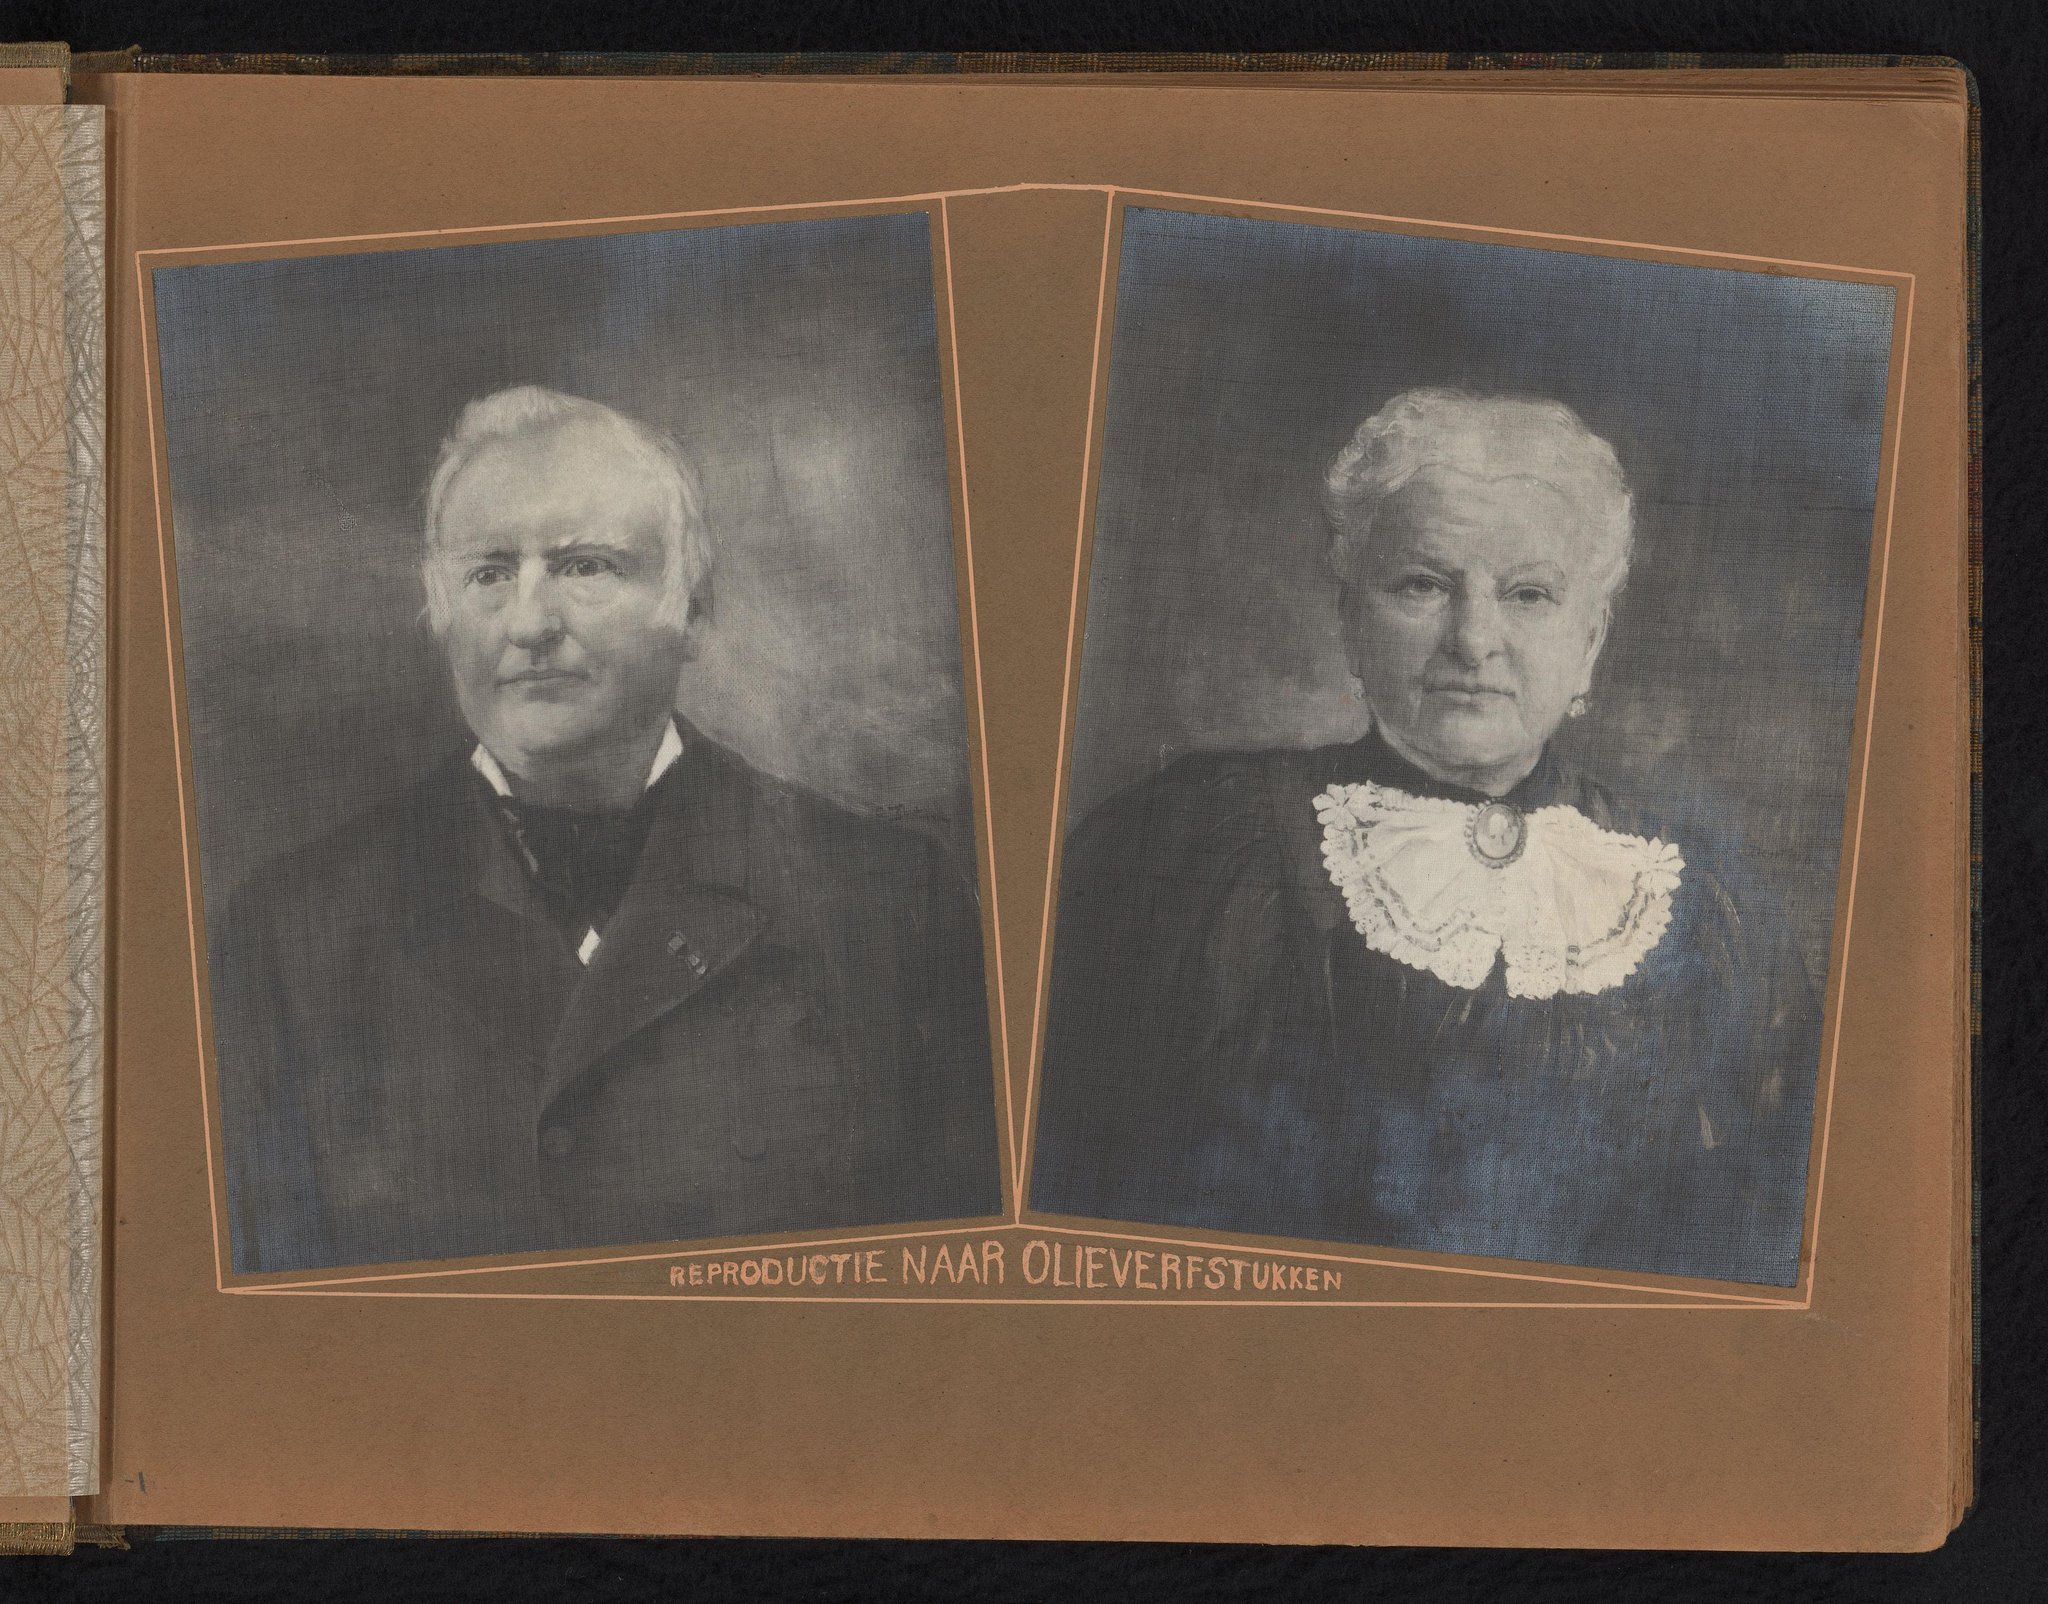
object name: reproduction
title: Fotoreproducties van twee geschilderde portretten van Max Kohnstamm en Sarah Kohnstamm-Wertheim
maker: Anonymous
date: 1920-1930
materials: paper, cardboard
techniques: gelatin silver print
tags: historical persons - bb - woman, historical persons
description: Deze foto's zijn onderdeel van een album.